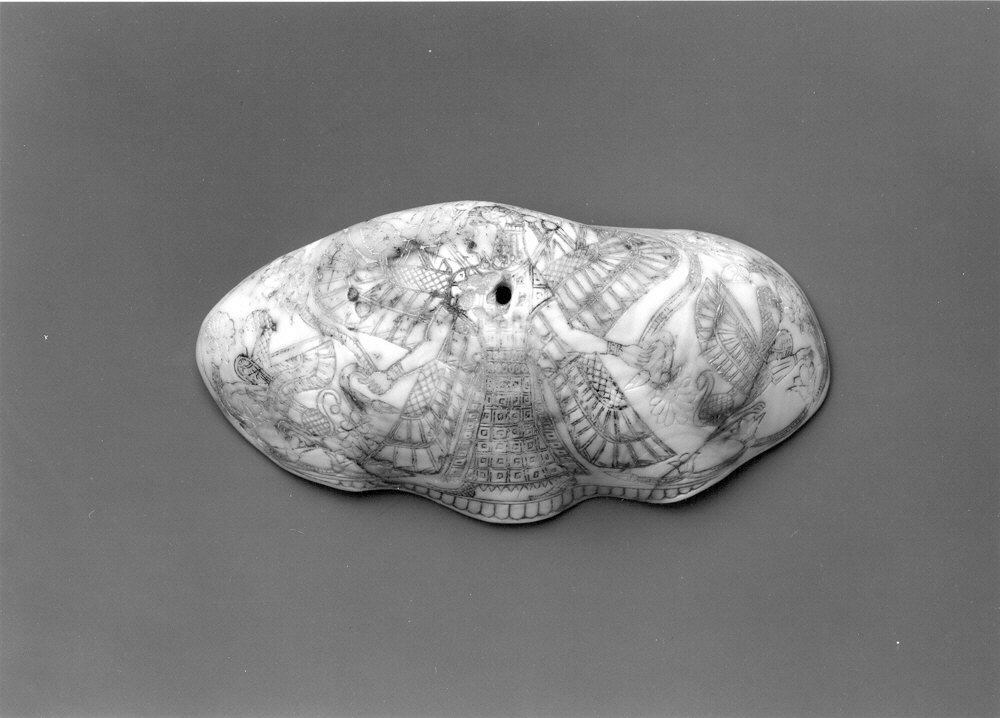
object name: relief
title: Shell engraved with winged female deity, sphinxes, and lotus plants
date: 700-600 BCE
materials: shell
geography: levant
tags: women,sphinx,lotuses,shells